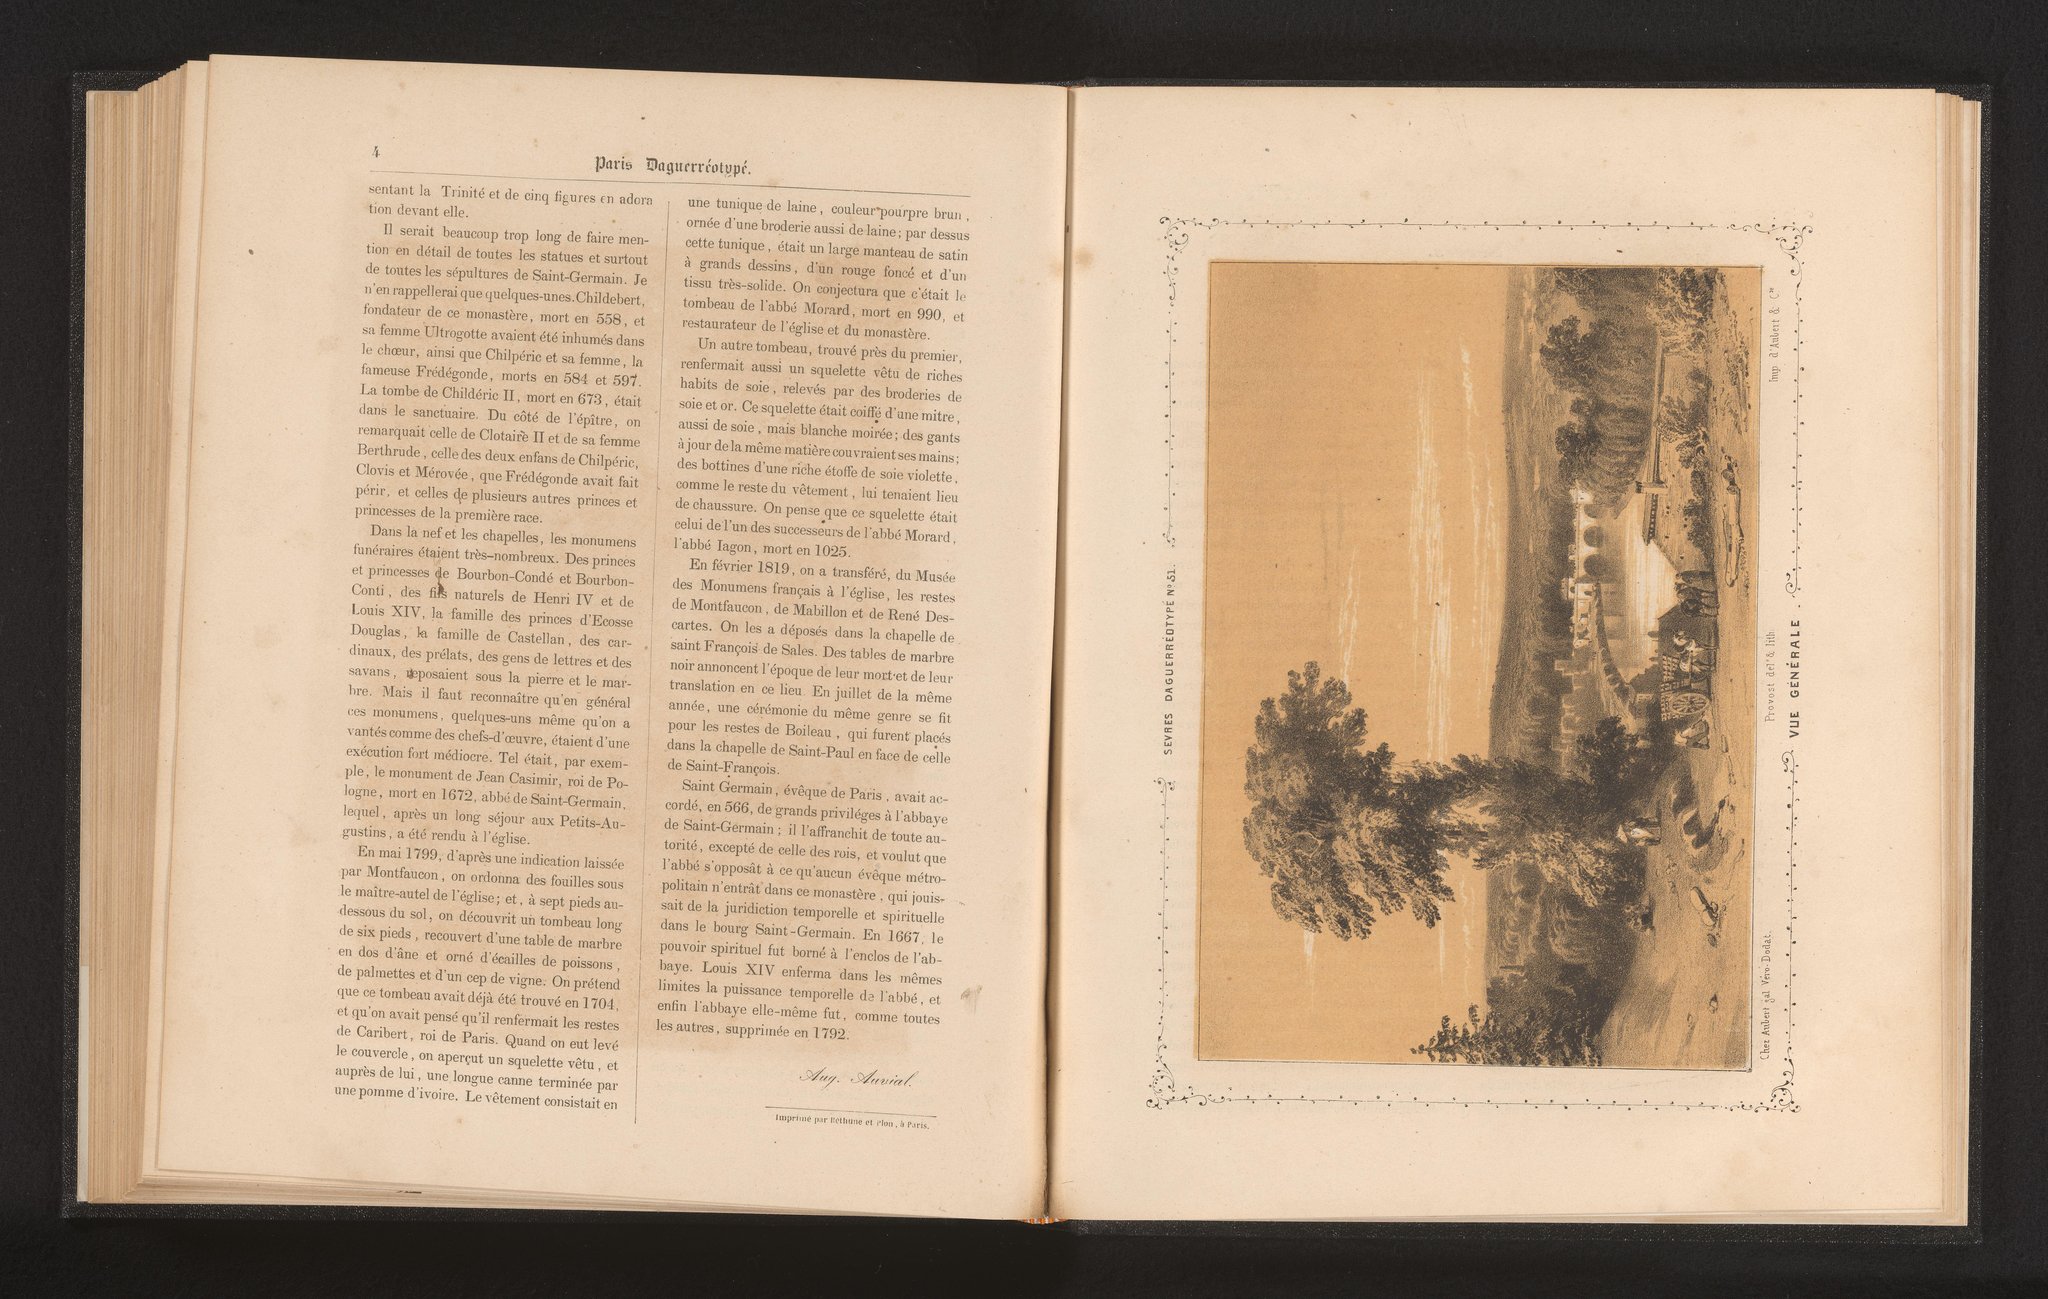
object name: print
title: Gezicht in Sèvres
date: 1839-1840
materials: paper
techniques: tone lithography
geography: paris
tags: city-view in general; 'veduta'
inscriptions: inscription: ‘SEVRES DAGUERRÉOTYPÉ No. 51.’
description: Prent op tweehonderdenderde ongenummerde pagina.